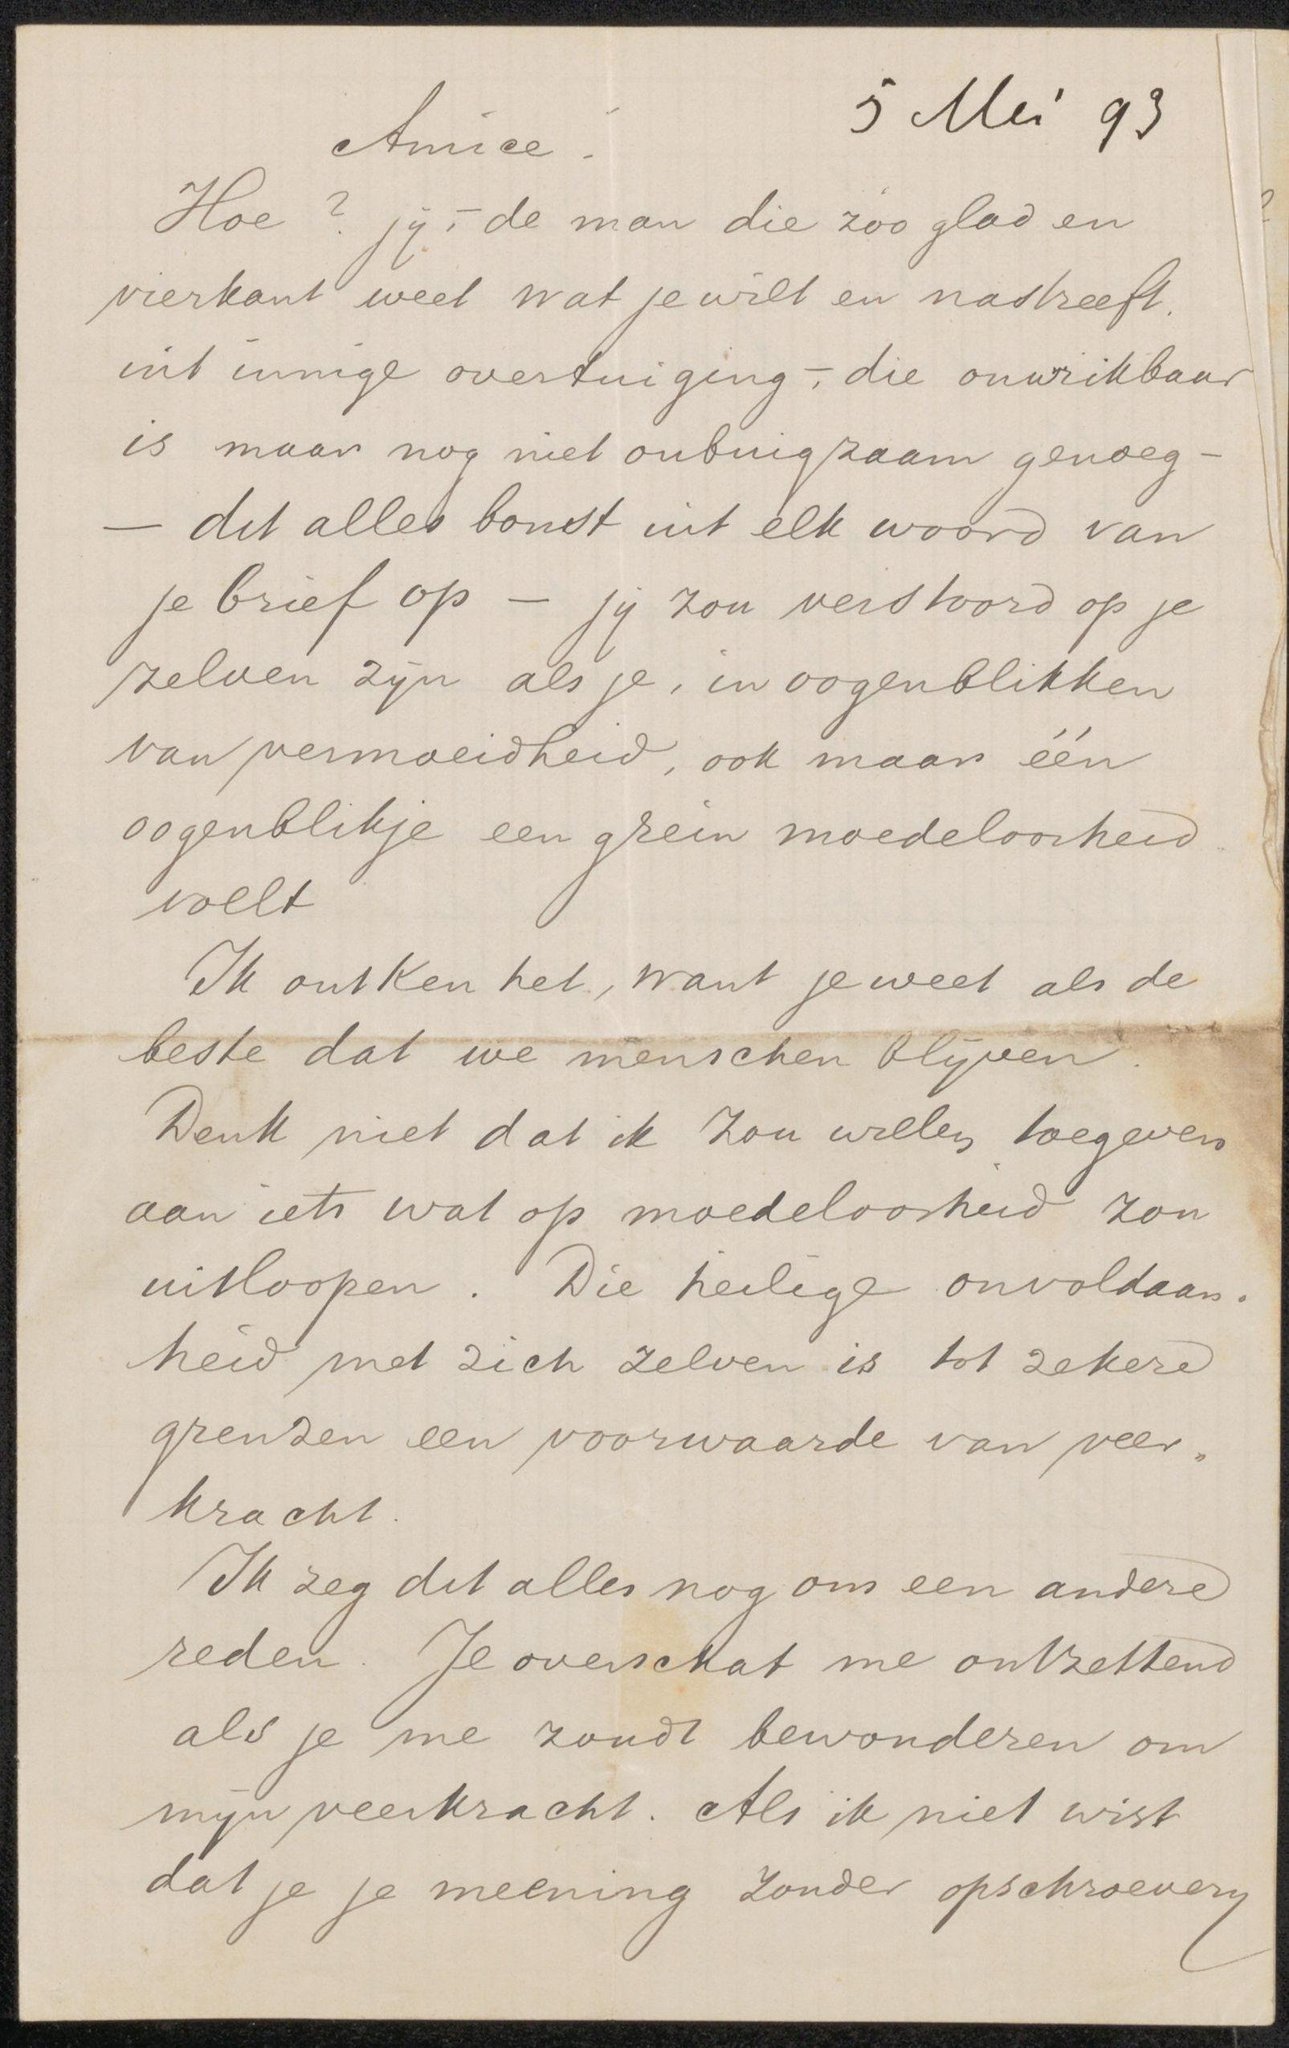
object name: letter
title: Brief aan Jan Veth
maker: martinus cornelis lebret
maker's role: verzamelaar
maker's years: 1833-1894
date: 1893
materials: ink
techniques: pen, writing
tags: jan veth, amsterdam, painter, draughtsman, passions, emotions, affections, charitable works, money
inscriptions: collector's mark: ‘RPK’